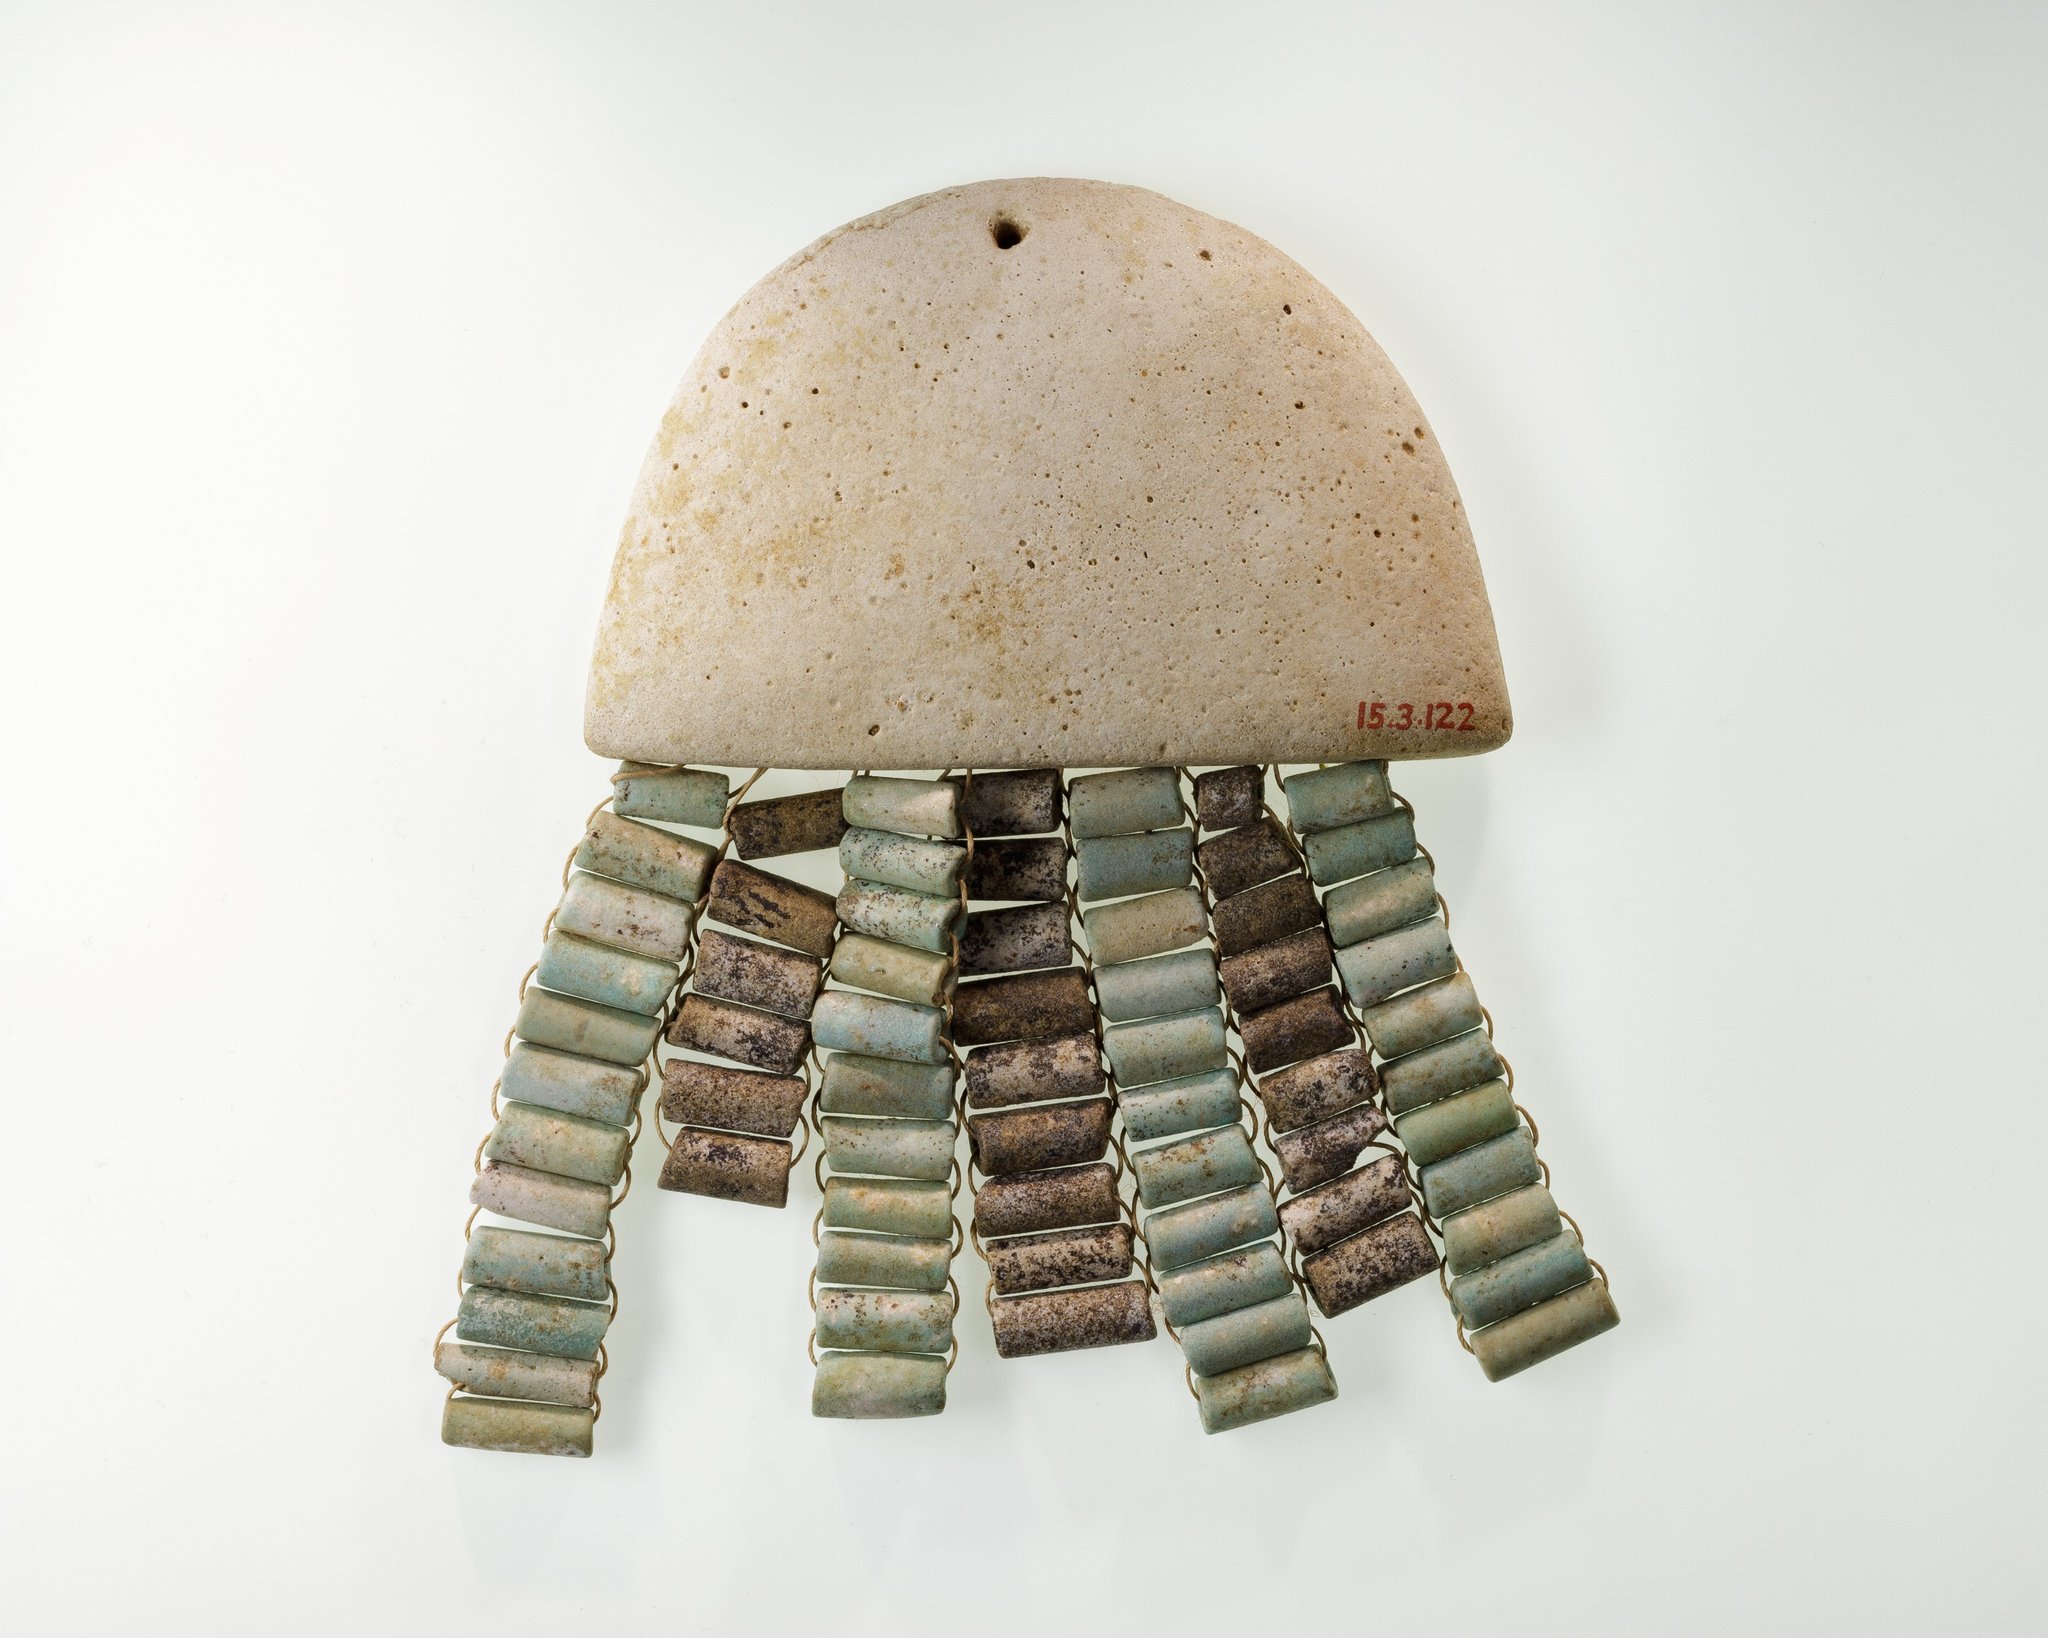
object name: broad collar terminal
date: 1850-1775 BCE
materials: faience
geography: egypt